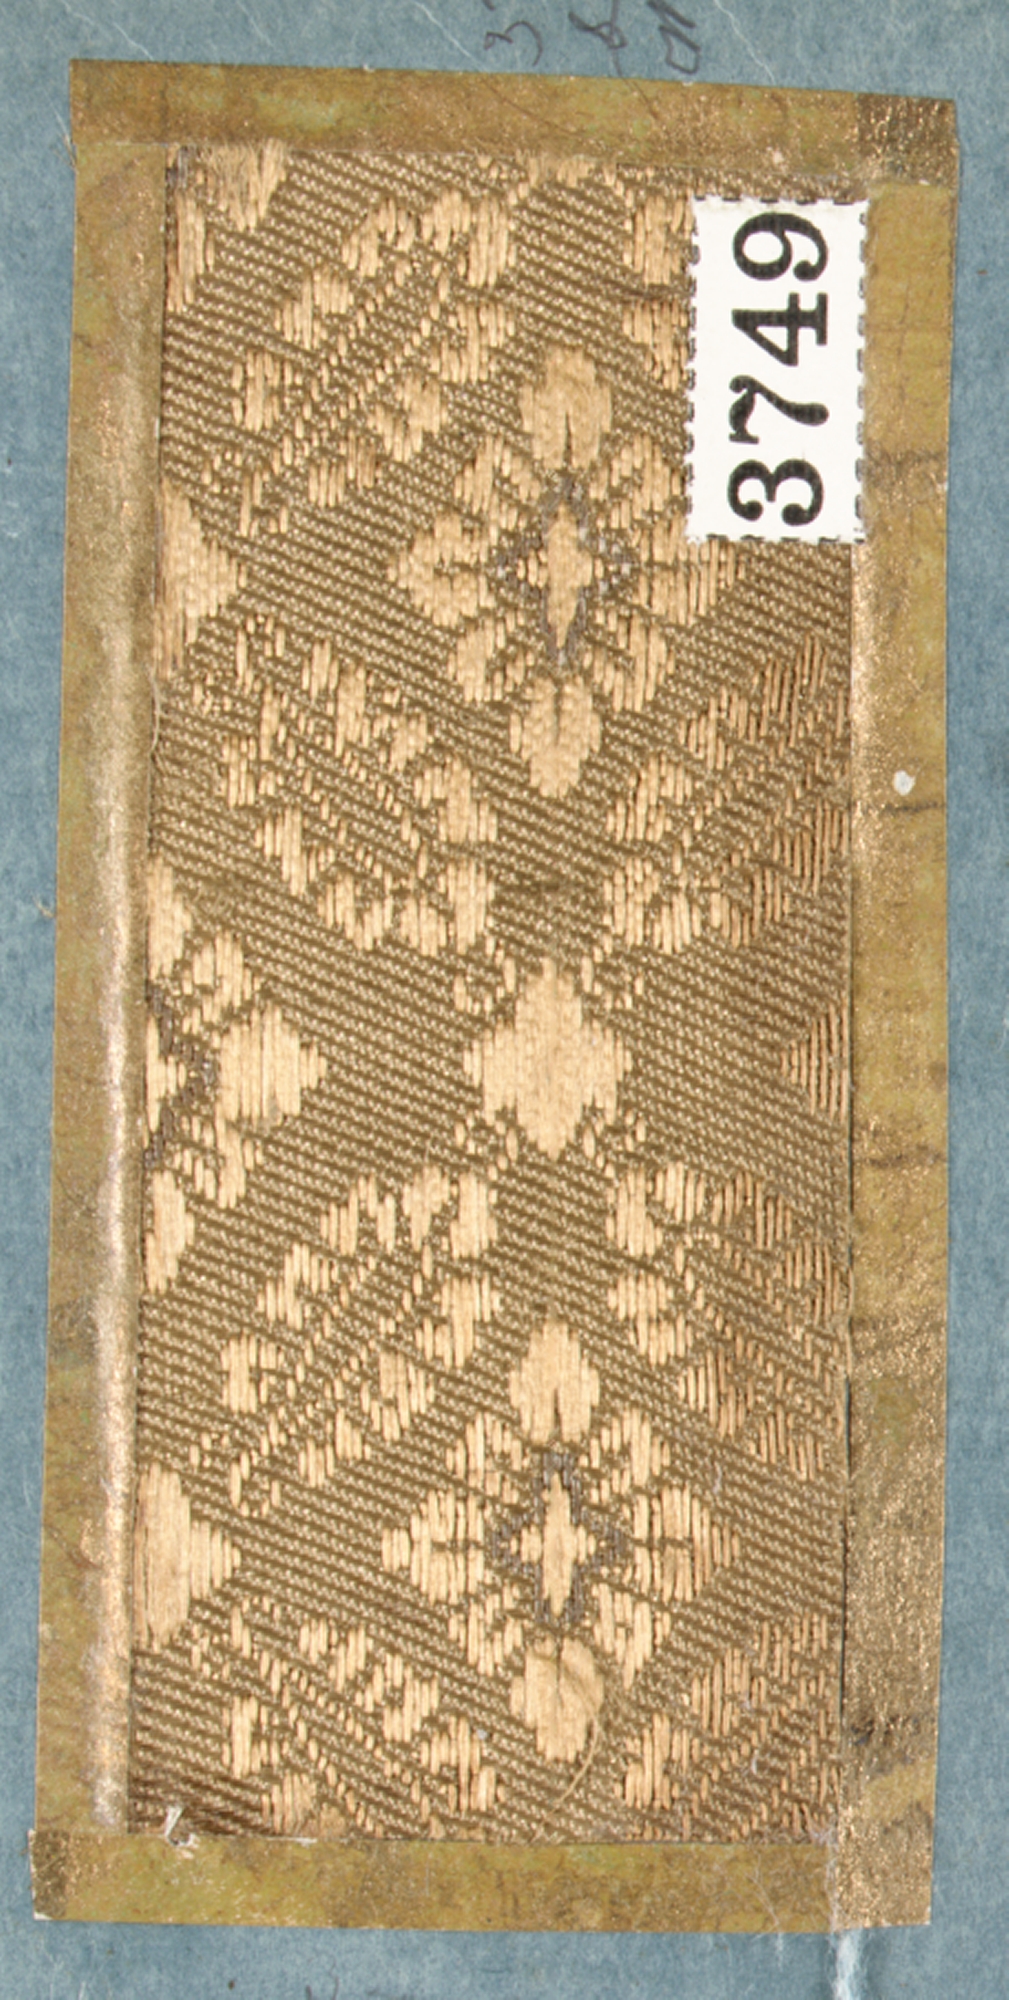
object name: sample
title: Textile Sample from Sample Book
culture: japanese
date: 1801-1900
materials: silk